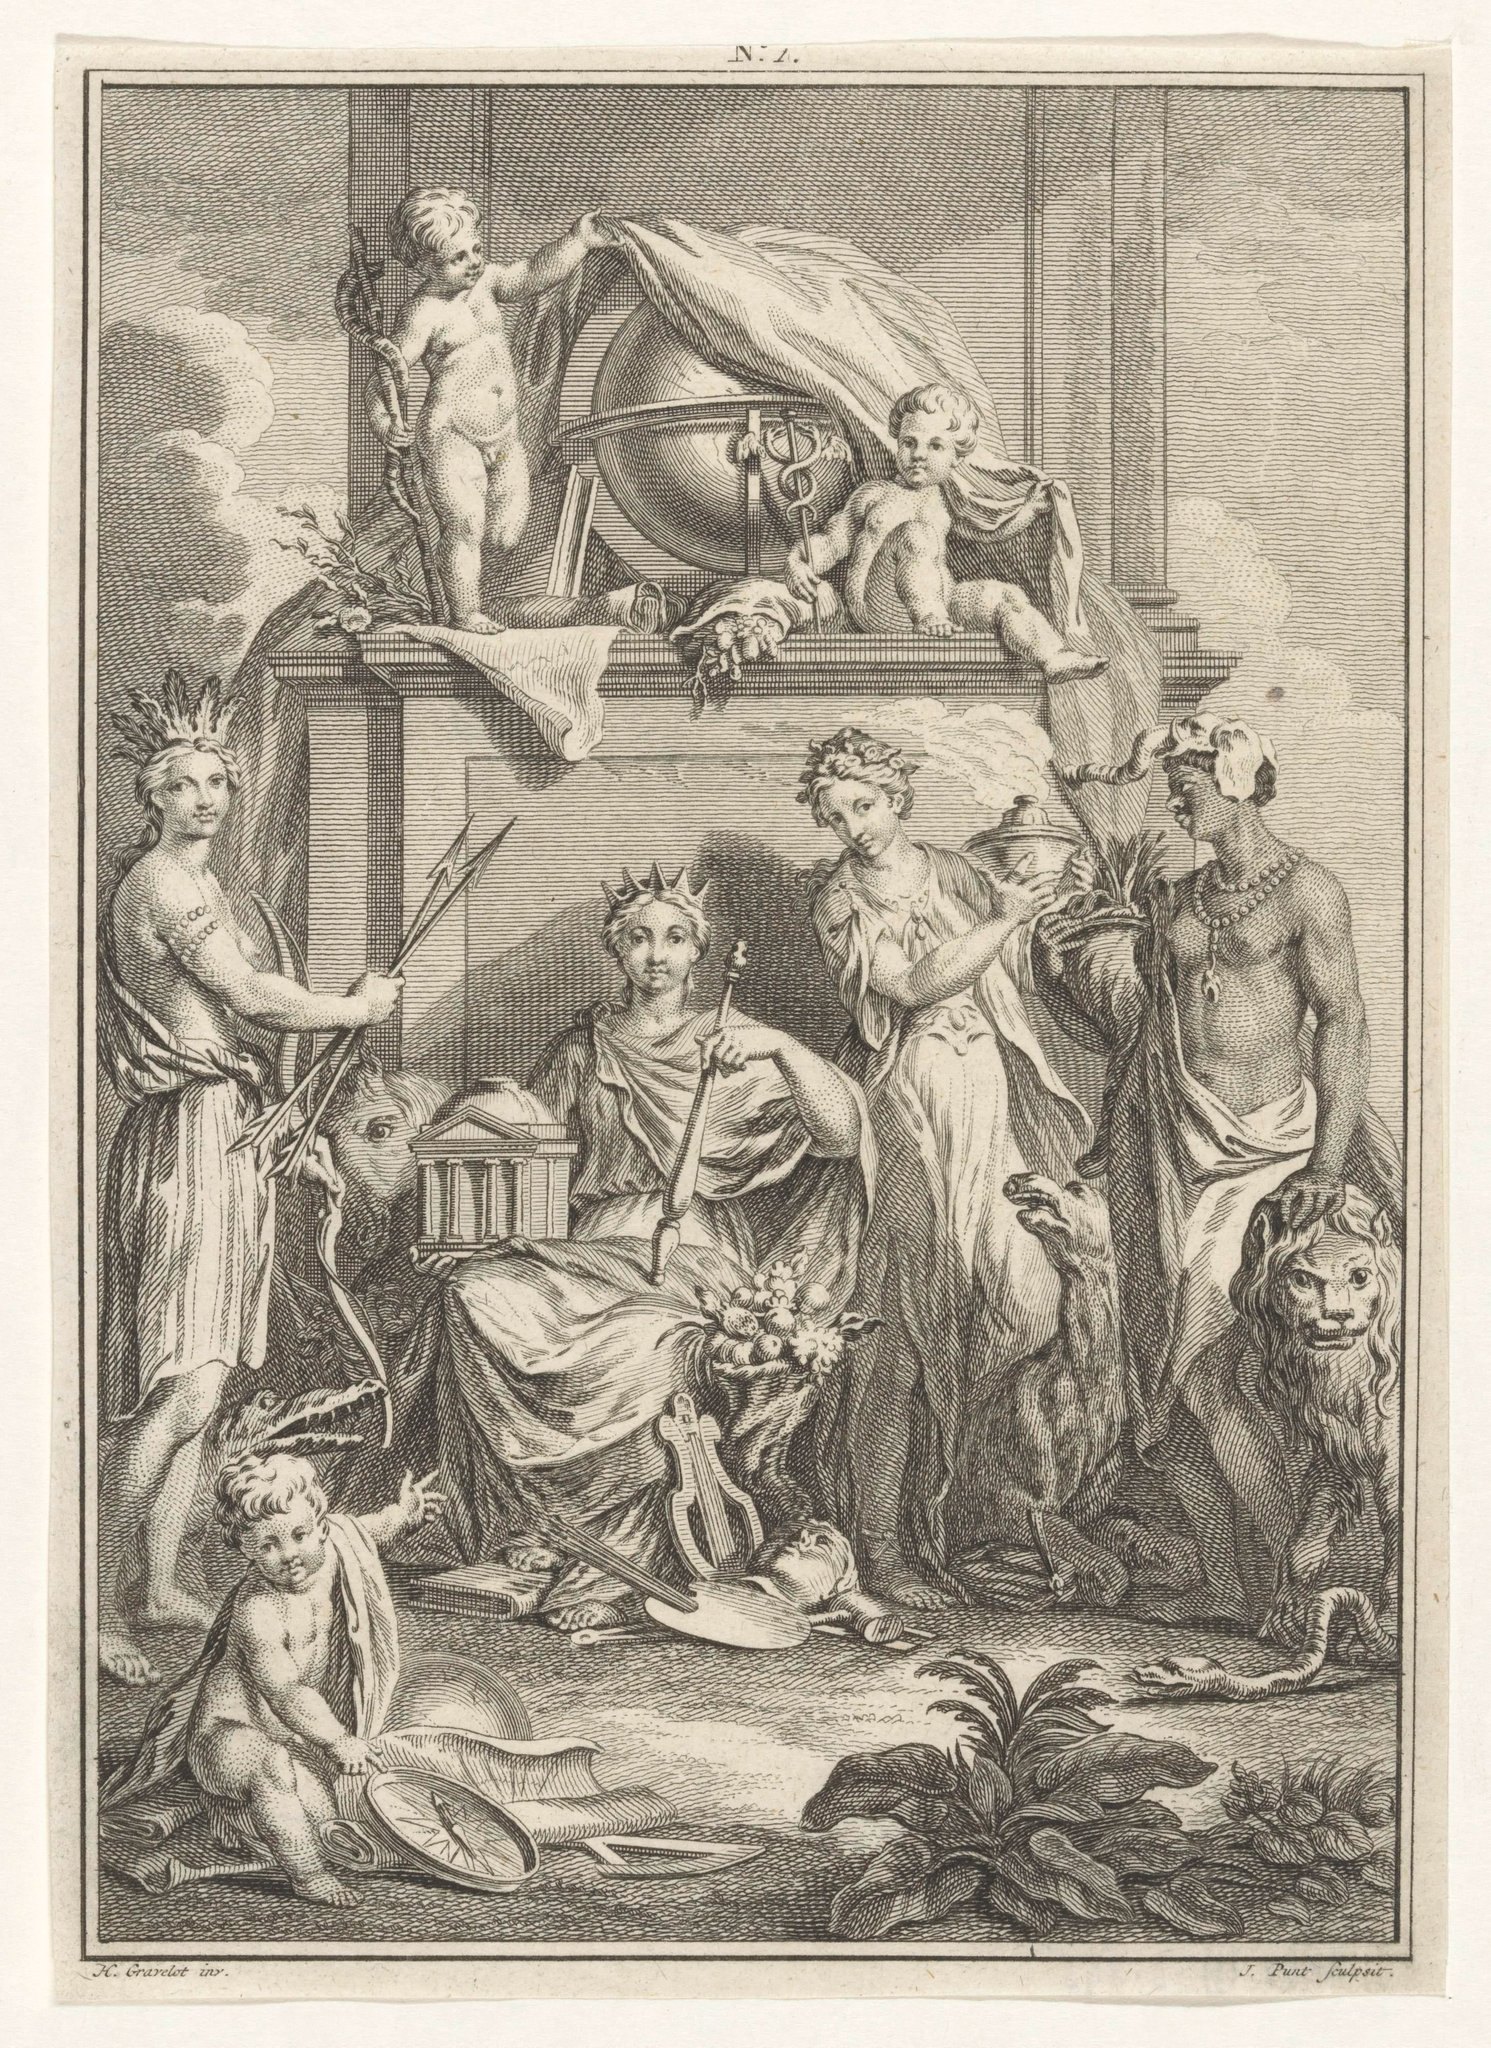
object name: print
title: Allegorische voorstelling met personificaties van vier werelddelen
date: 1721-1779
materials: paper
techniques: engraving, etching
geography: netherlands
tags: globe, continents represented allegorically, cupids: 'amores', 'amoretti', 'putti'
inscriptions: collector's mark: Lugt 2228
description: Een putto met meetinstrumenten wijst op de vier vrouwelijke personificaties van de werelddelen Amerika, Europa, Azië en Afrika. Achter hen onthullen twee putti met esculaap en caduceus een globe. Midden boven N. 1.